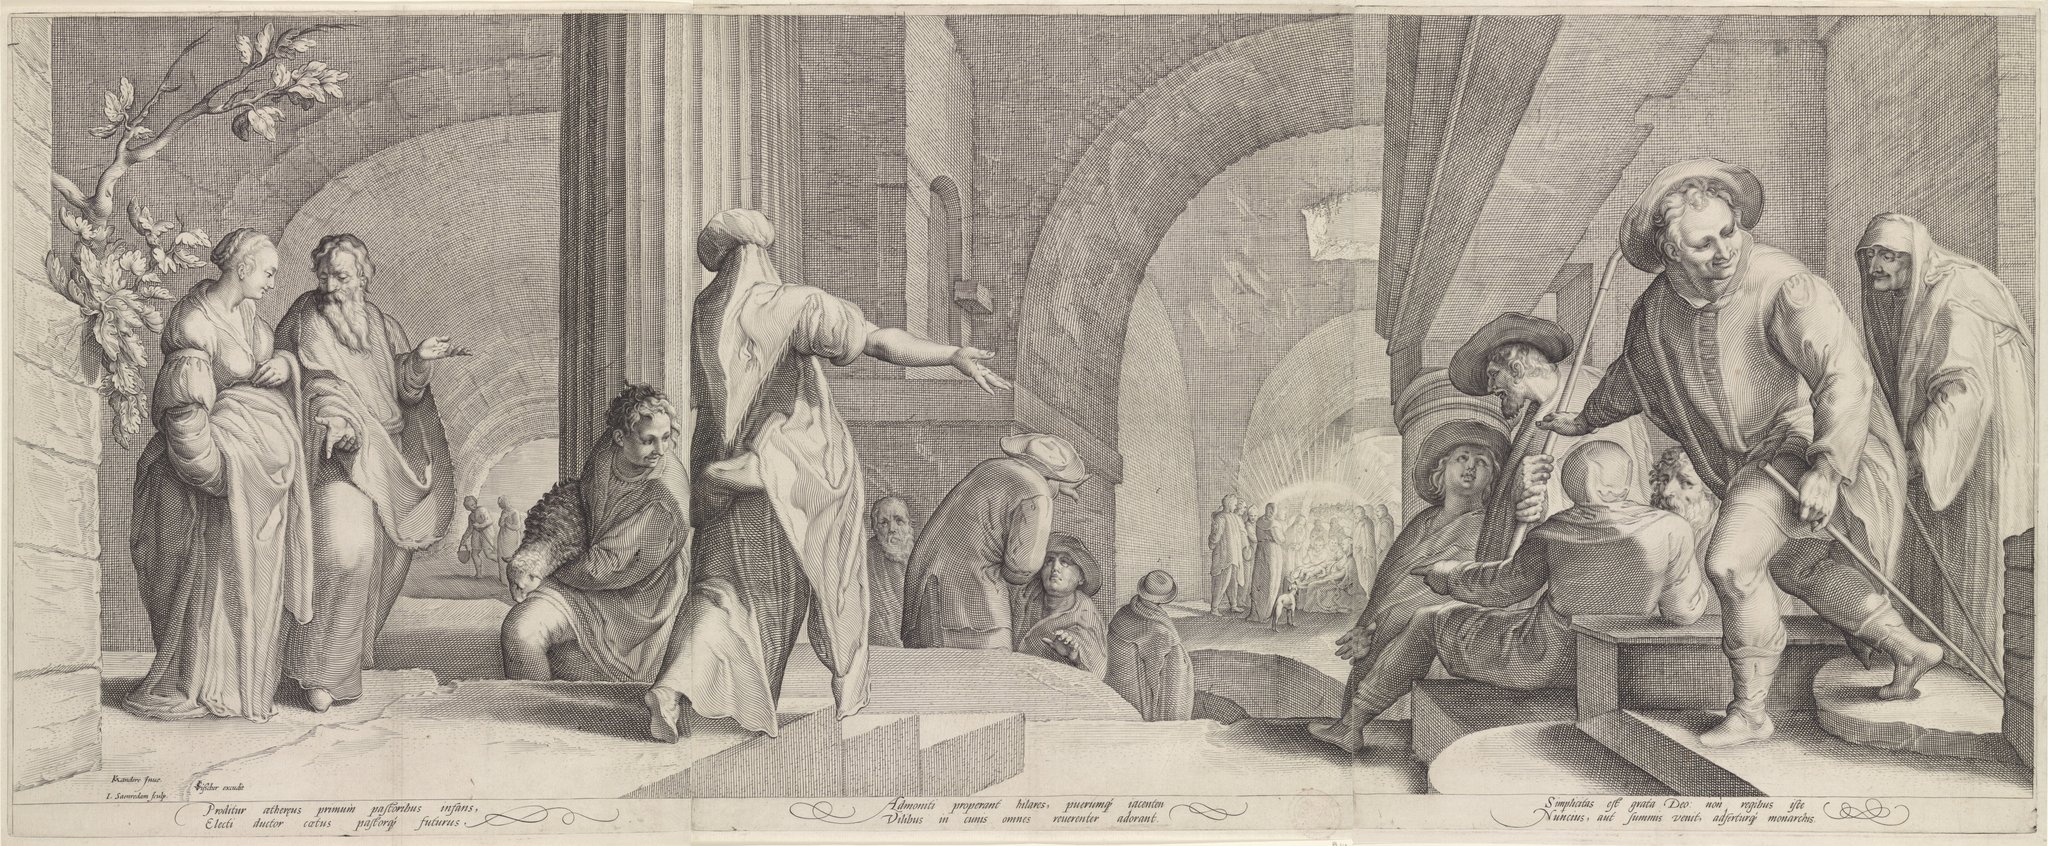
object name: print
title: Aanbidding door de herders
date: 1601-1652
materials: paper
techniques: engraving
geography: amsterdam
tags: adoration of the christ-child by the shepherds; mary and joseph present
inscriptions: collector's mark: Lugt 240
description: Vooraan enkele herders in een gewelfde ruimte. Midden achter nog meer herders rond Maria, Jozef en het Christuskind. Onder de voorstelling een zesregelige, Latijnse tekst met een toelichting op de scène.